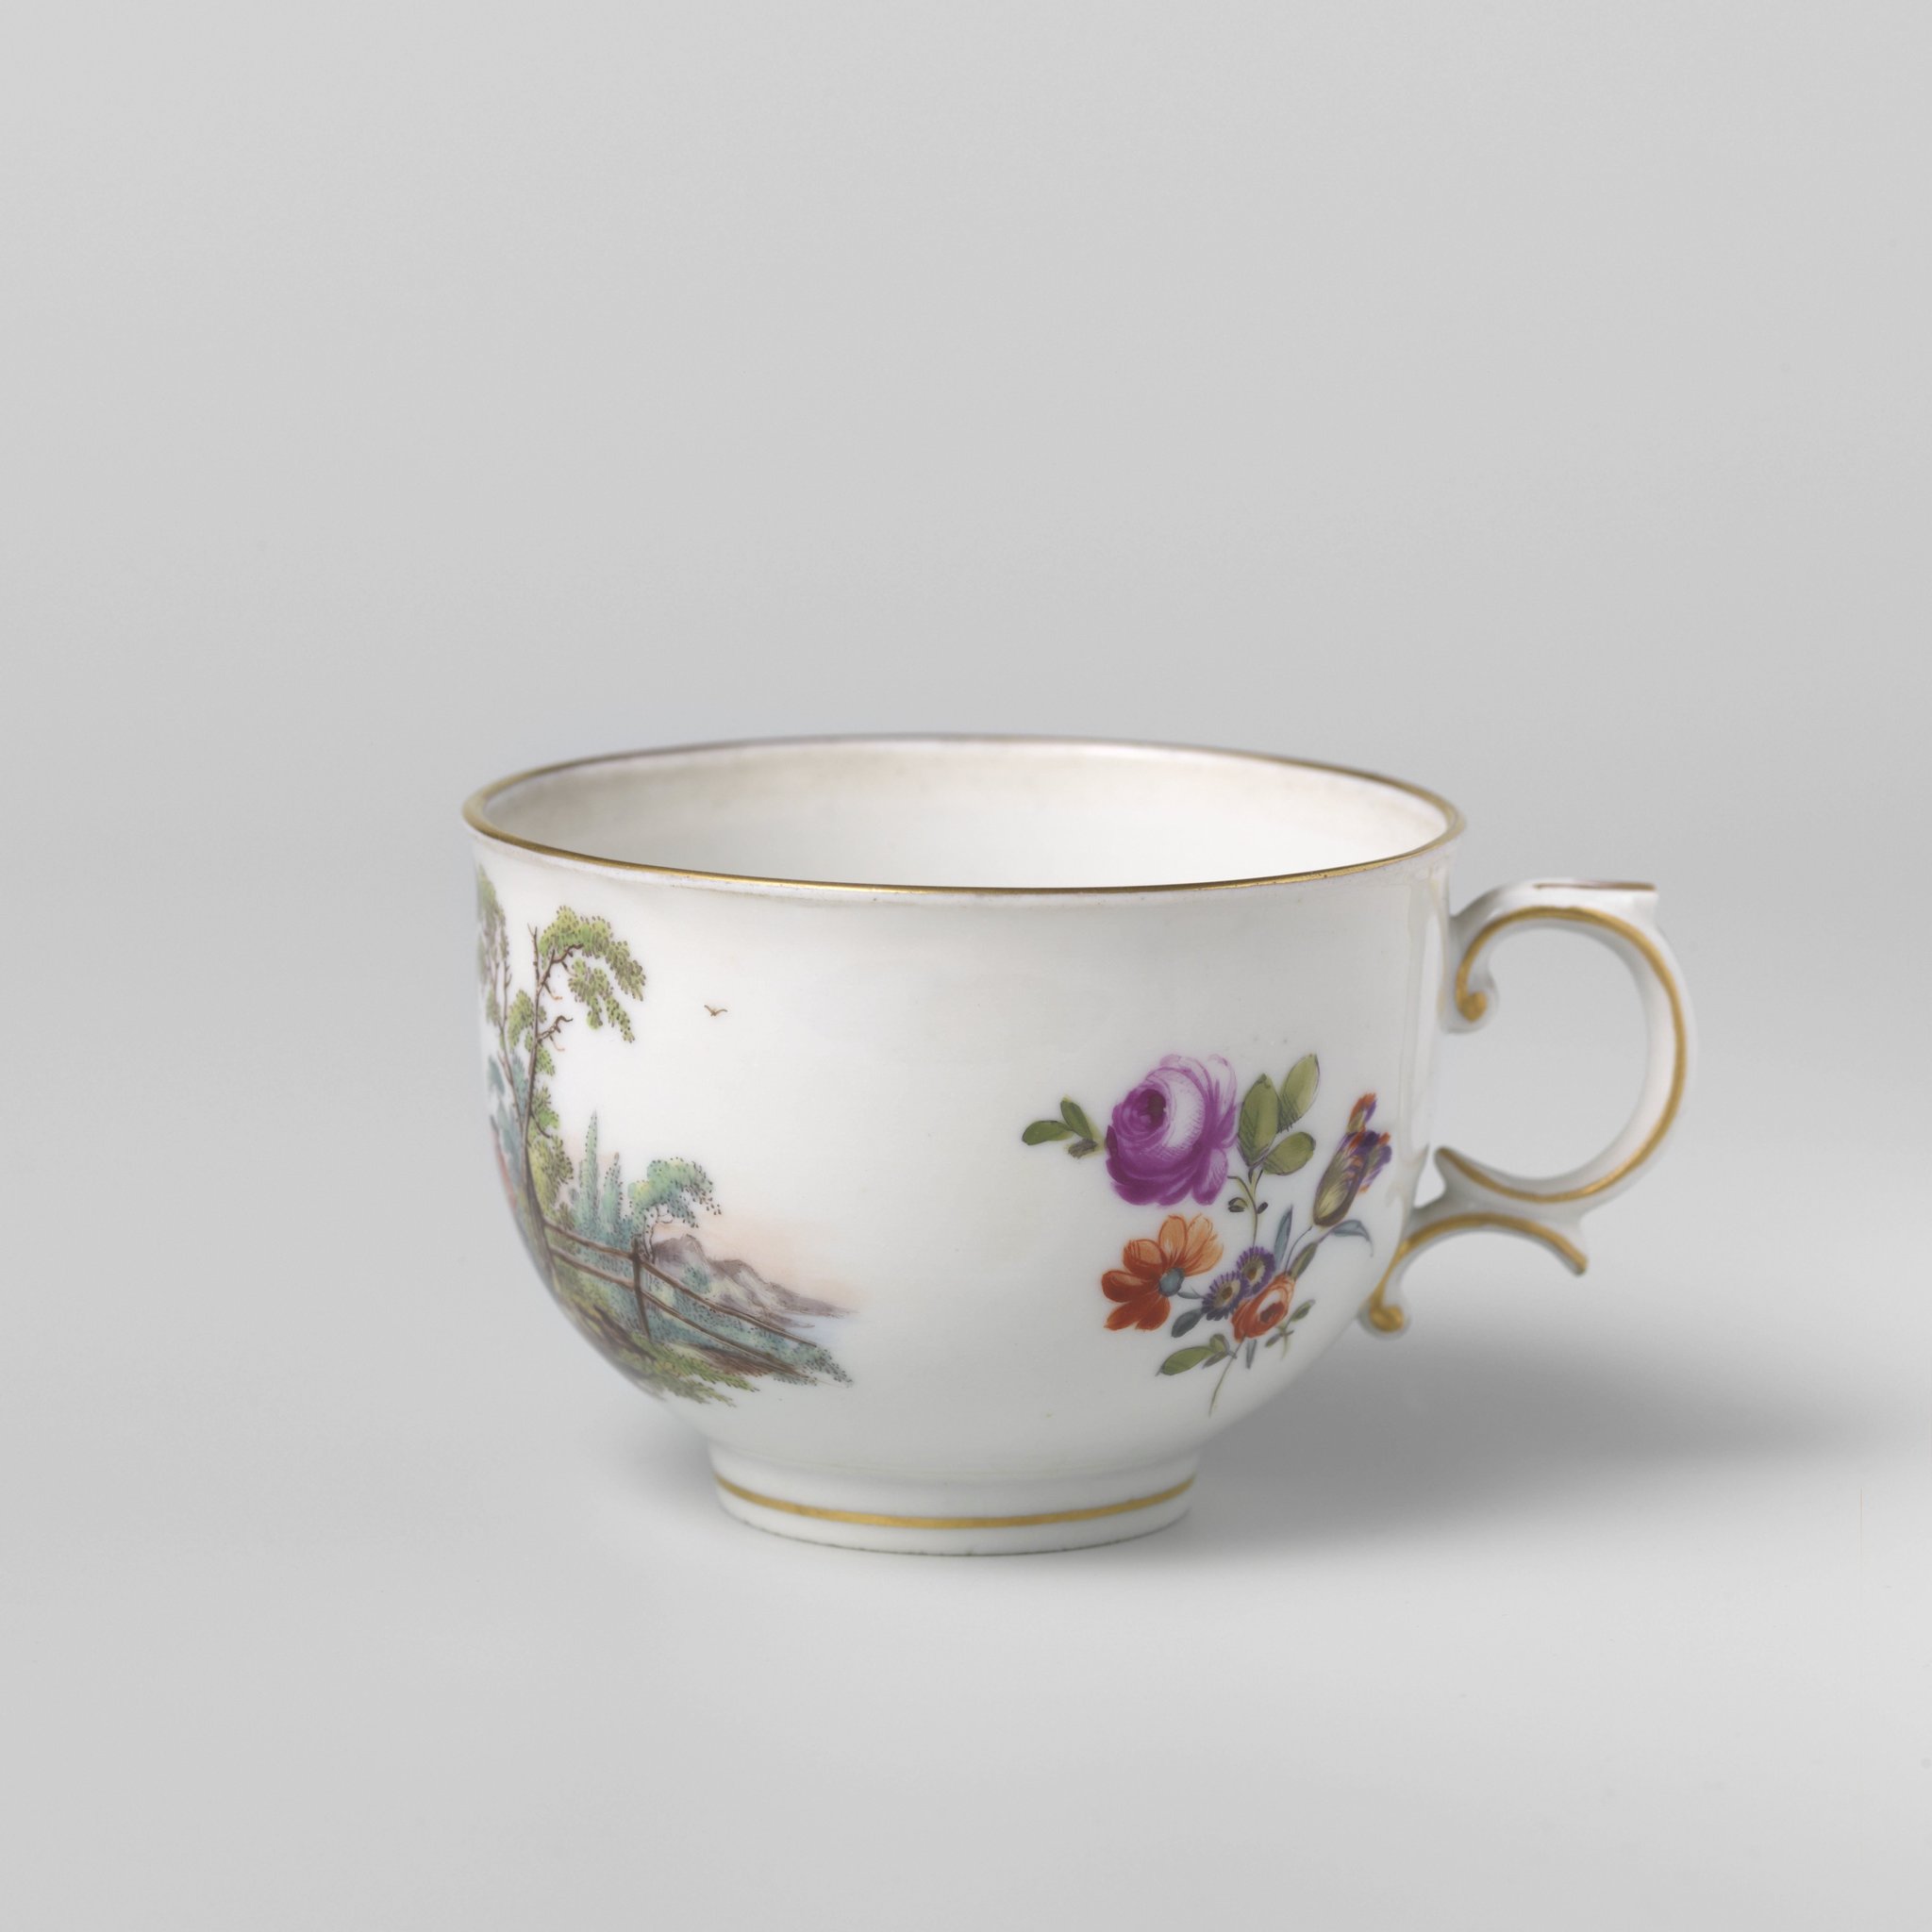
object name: tea service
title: Cup with a landscape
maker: Anonymous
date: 1765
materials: glaze, gold, paint, porcelain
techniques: firing, forming, gilding, vitrification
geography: sint-petersburg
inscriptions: mark: ‘monogram’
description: Kop van porselein met een rocaille oor, beschilderd op het glazuur in emailkleuren en goud. Op de buitenwand een landschap met op de voorgrond twee mannen en een vrouw met een mand op haar rug. Hiernaast boeketten en strooibloemen. Gouden lijnen op de voet en het oor. Gouden rand. Gemerkt met het monogram van Catherine II van Rusland. Mogelijk een 19e of 20e eeuwse vervalsing.